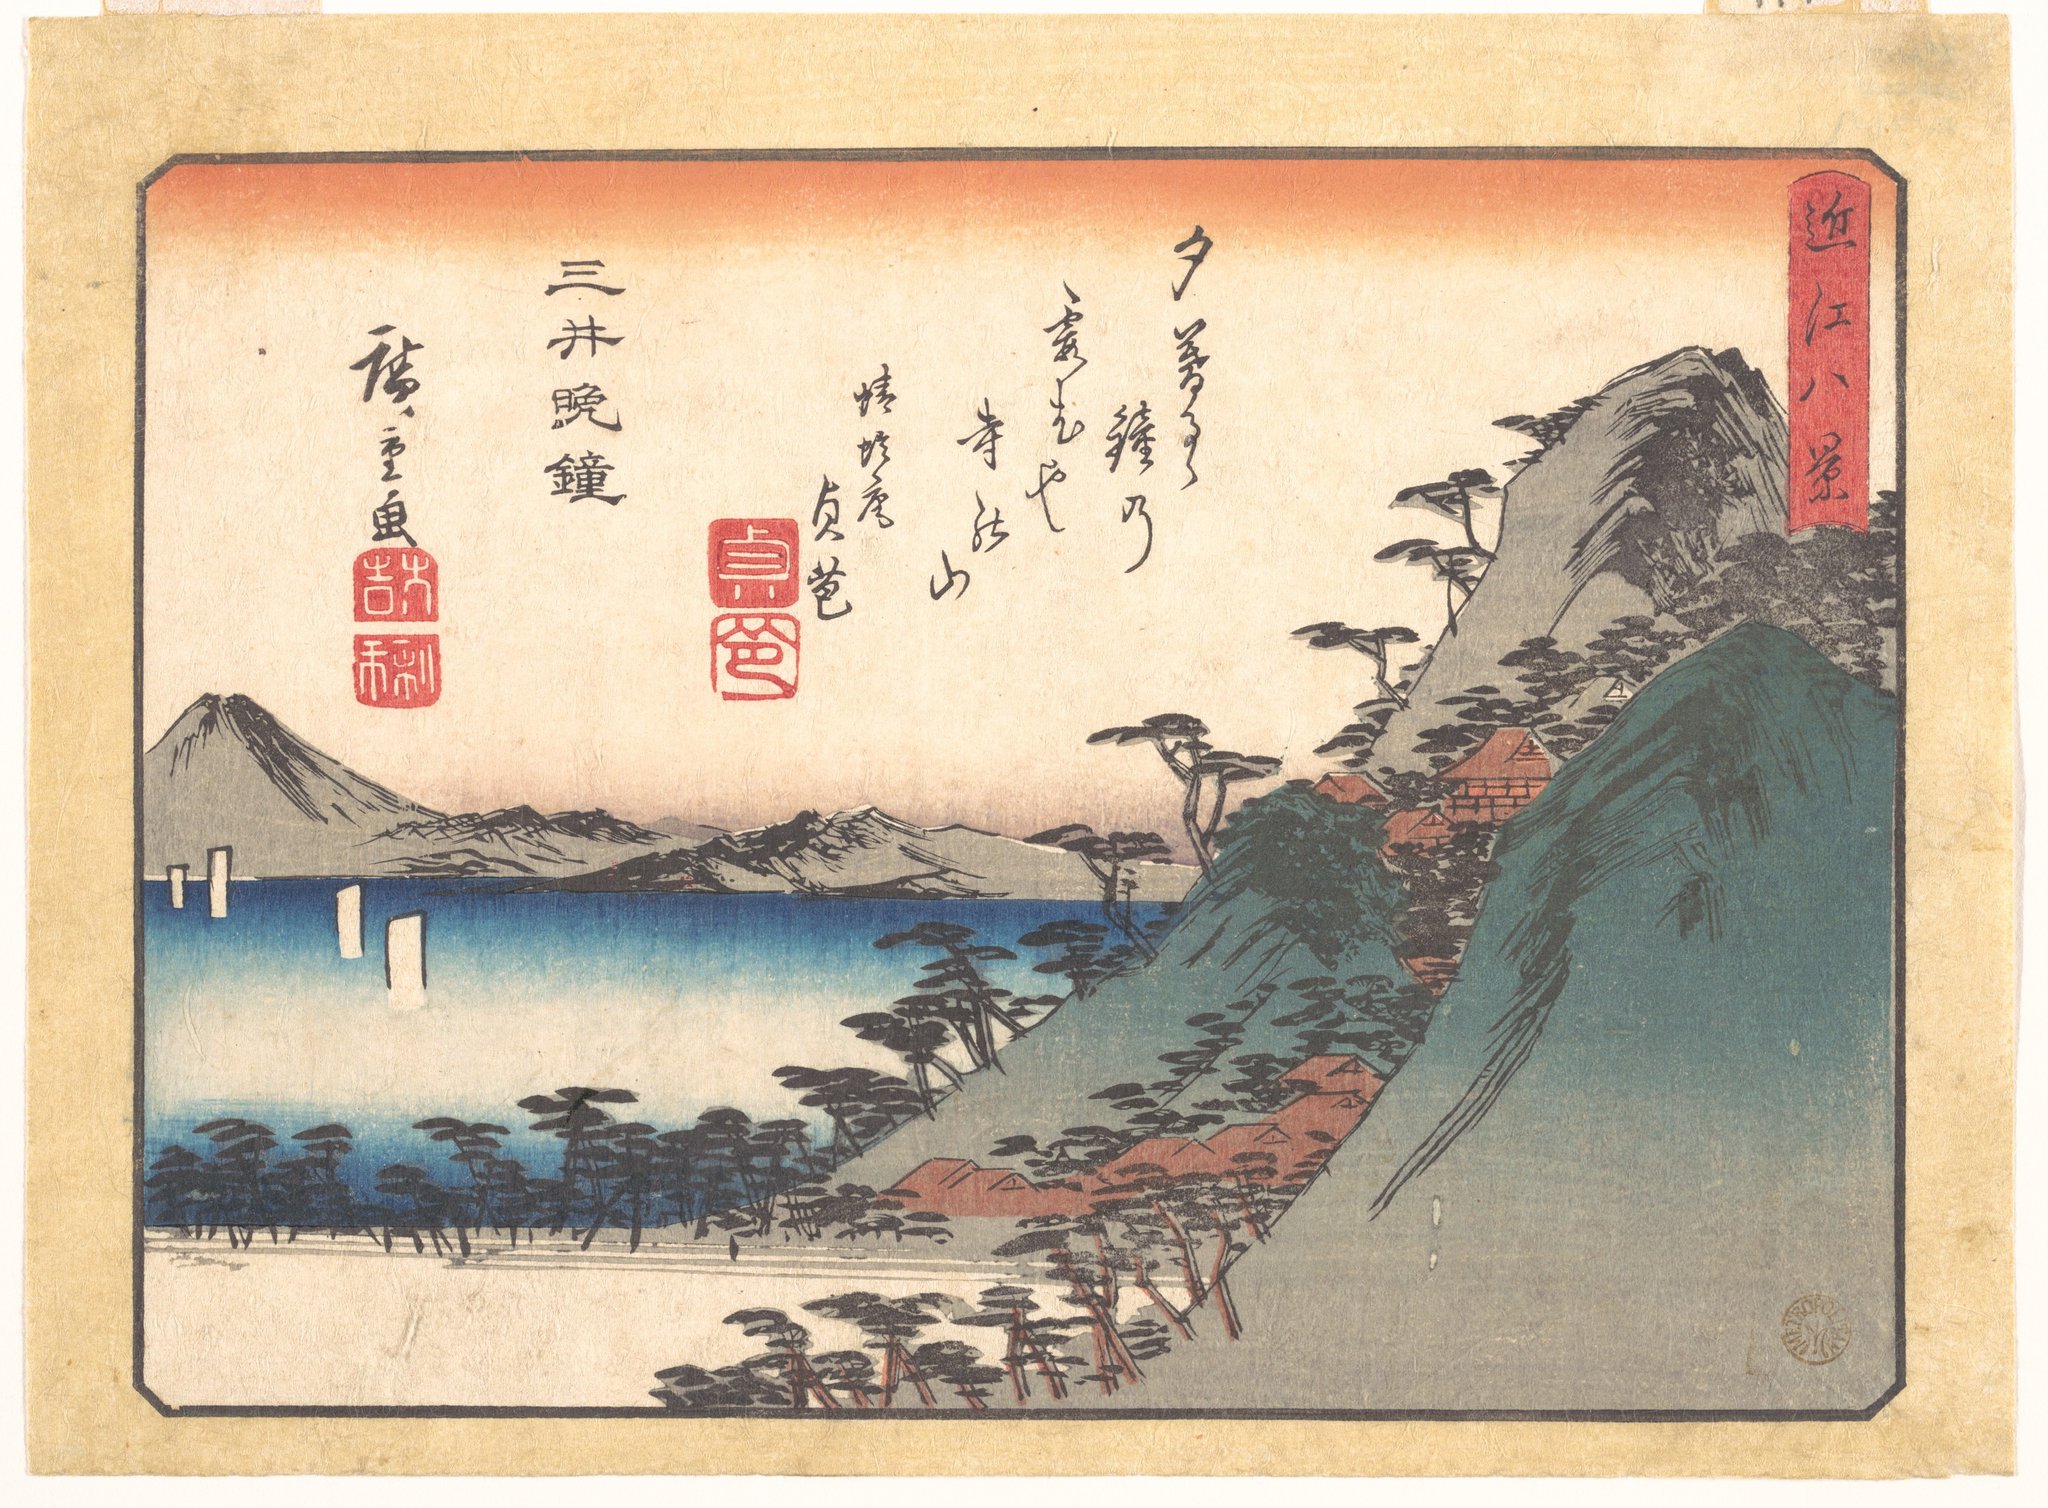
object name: print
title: Evening Bell at Miidera Temple, from the series Eight Views of Ōmi (Ōmi hakkei)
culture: japanese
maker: utagawa hiroshige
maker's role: artist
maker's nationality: japanese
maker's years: 1797-1858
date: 1834-1835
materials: ink, paper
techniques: woodblock print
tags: buildings,mountains,trees